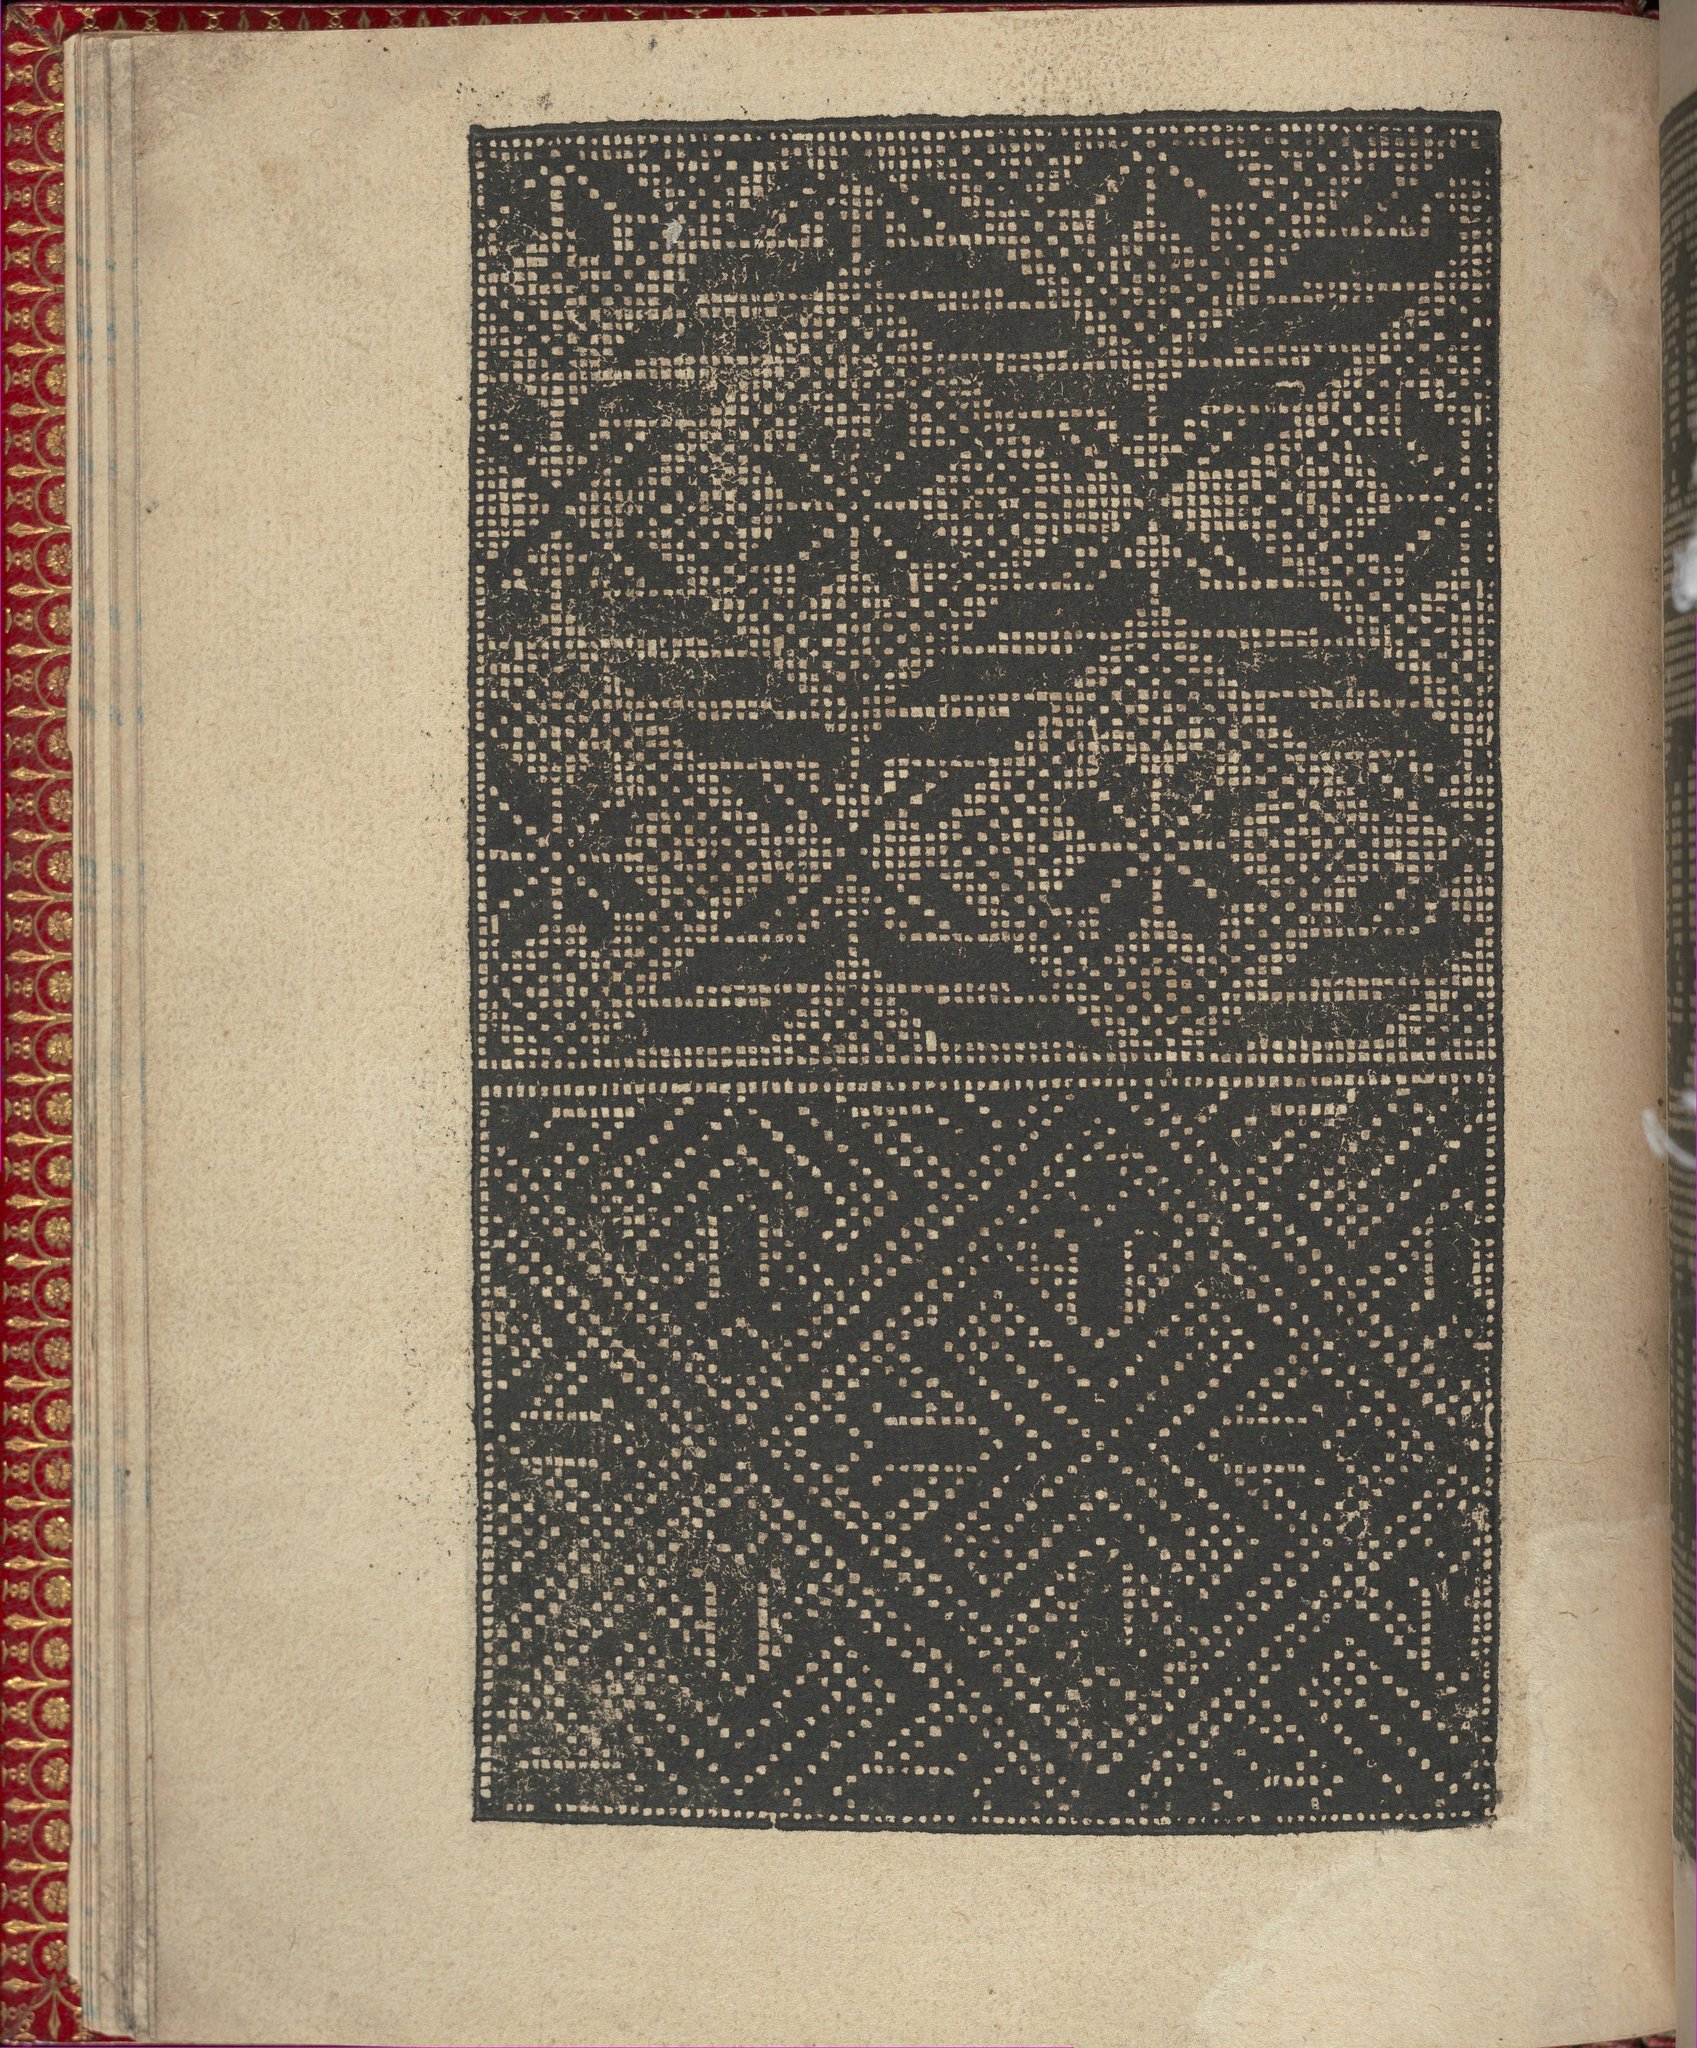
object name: book print ornament architecture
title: Ce est ung tractat de la noble art de leguille ascavoir ouvraiges de spaigne... page 7 (recto)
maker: willem vosterman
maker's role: printer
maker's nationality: netherlandish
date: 1527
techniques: woodcut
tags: ornament